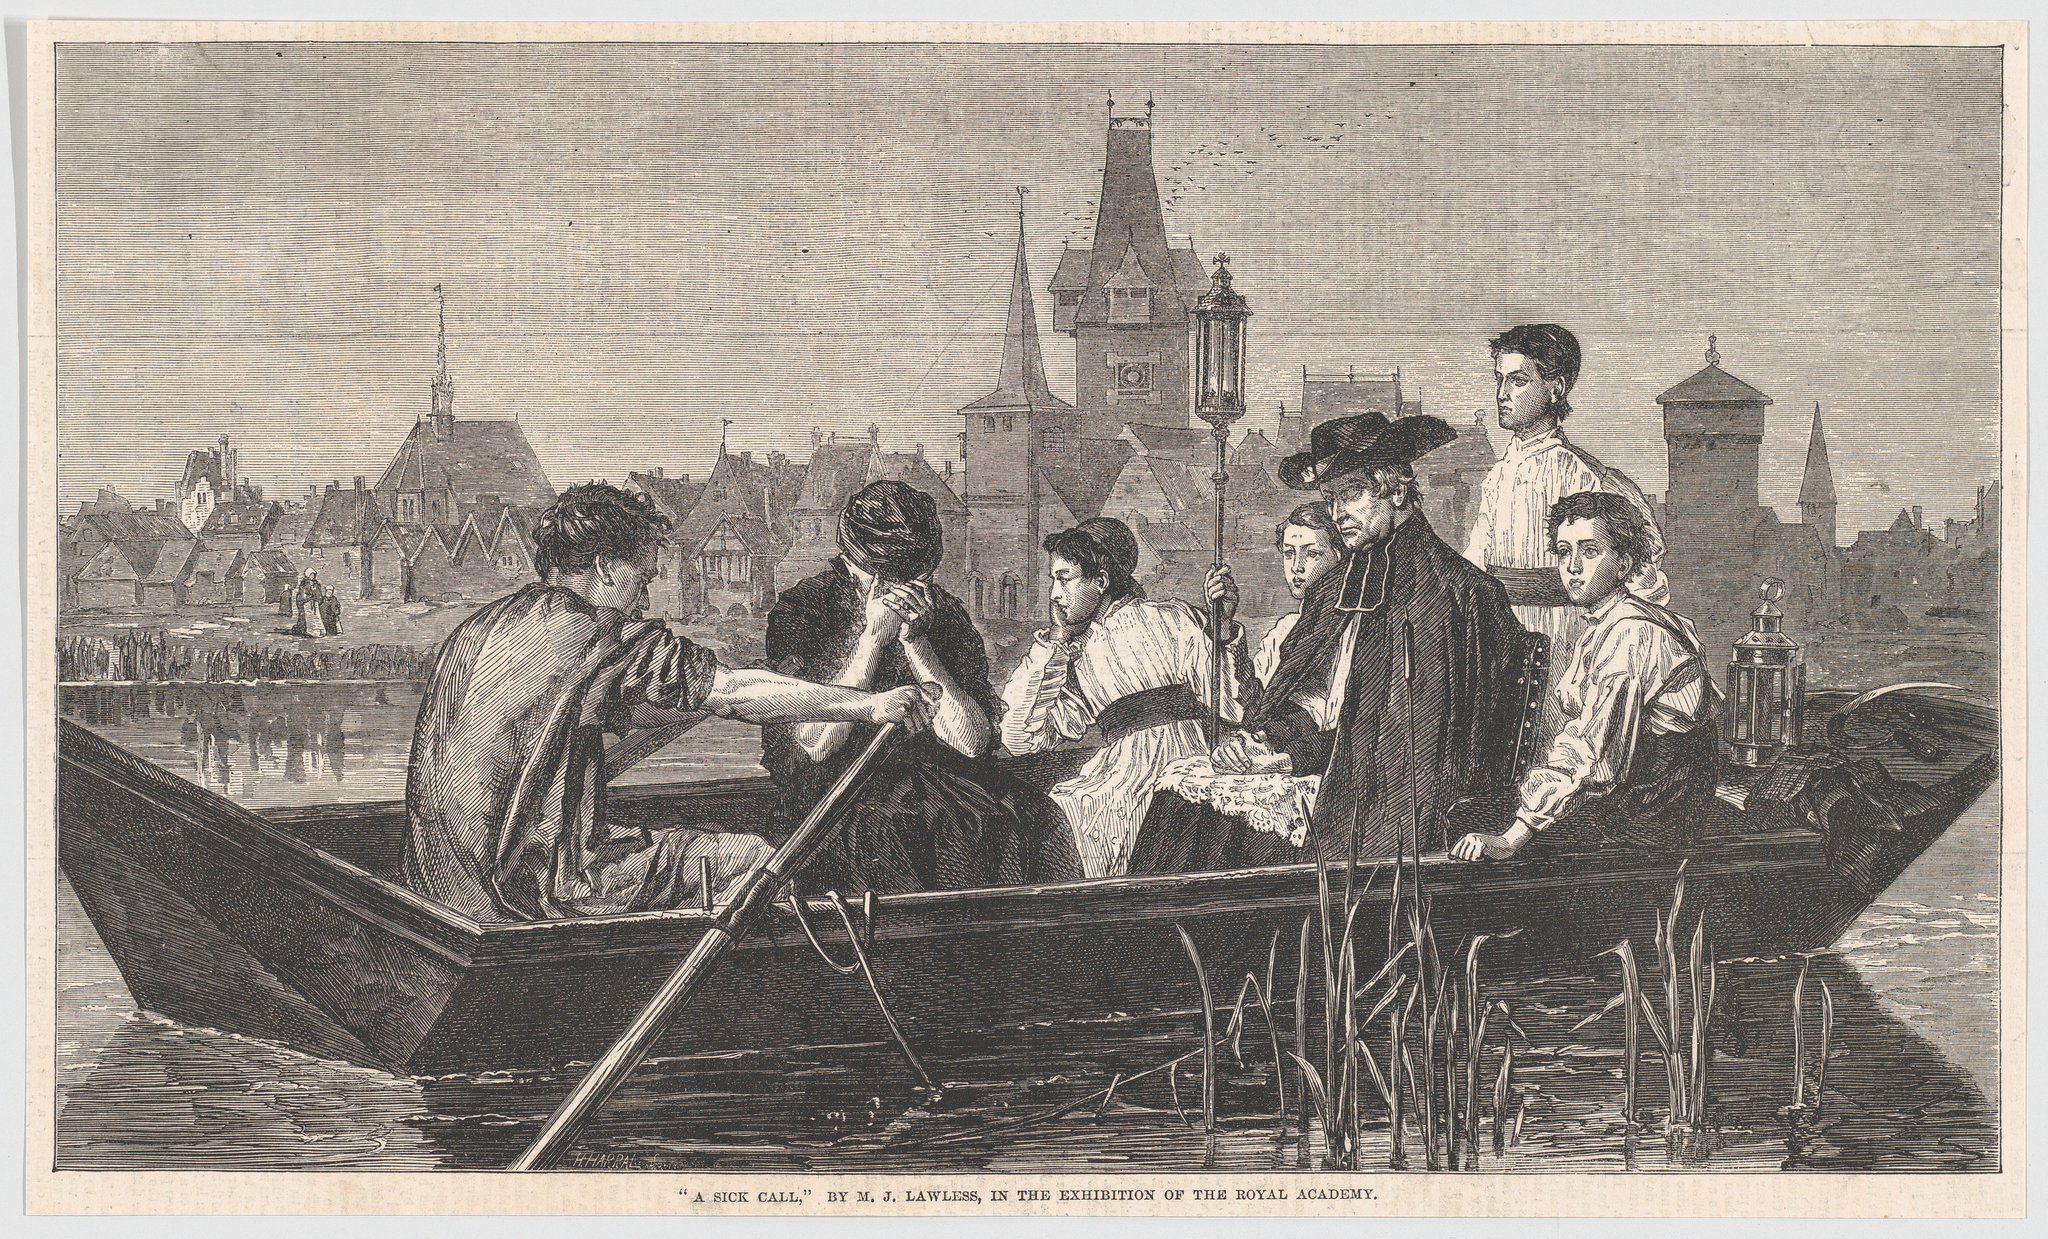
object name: print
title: A Sick Call, from "Illustrated London News"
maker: horace harral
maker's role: engraver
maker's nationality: british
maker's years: 1817-1905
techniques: engraving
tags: sadness,men,women,boats